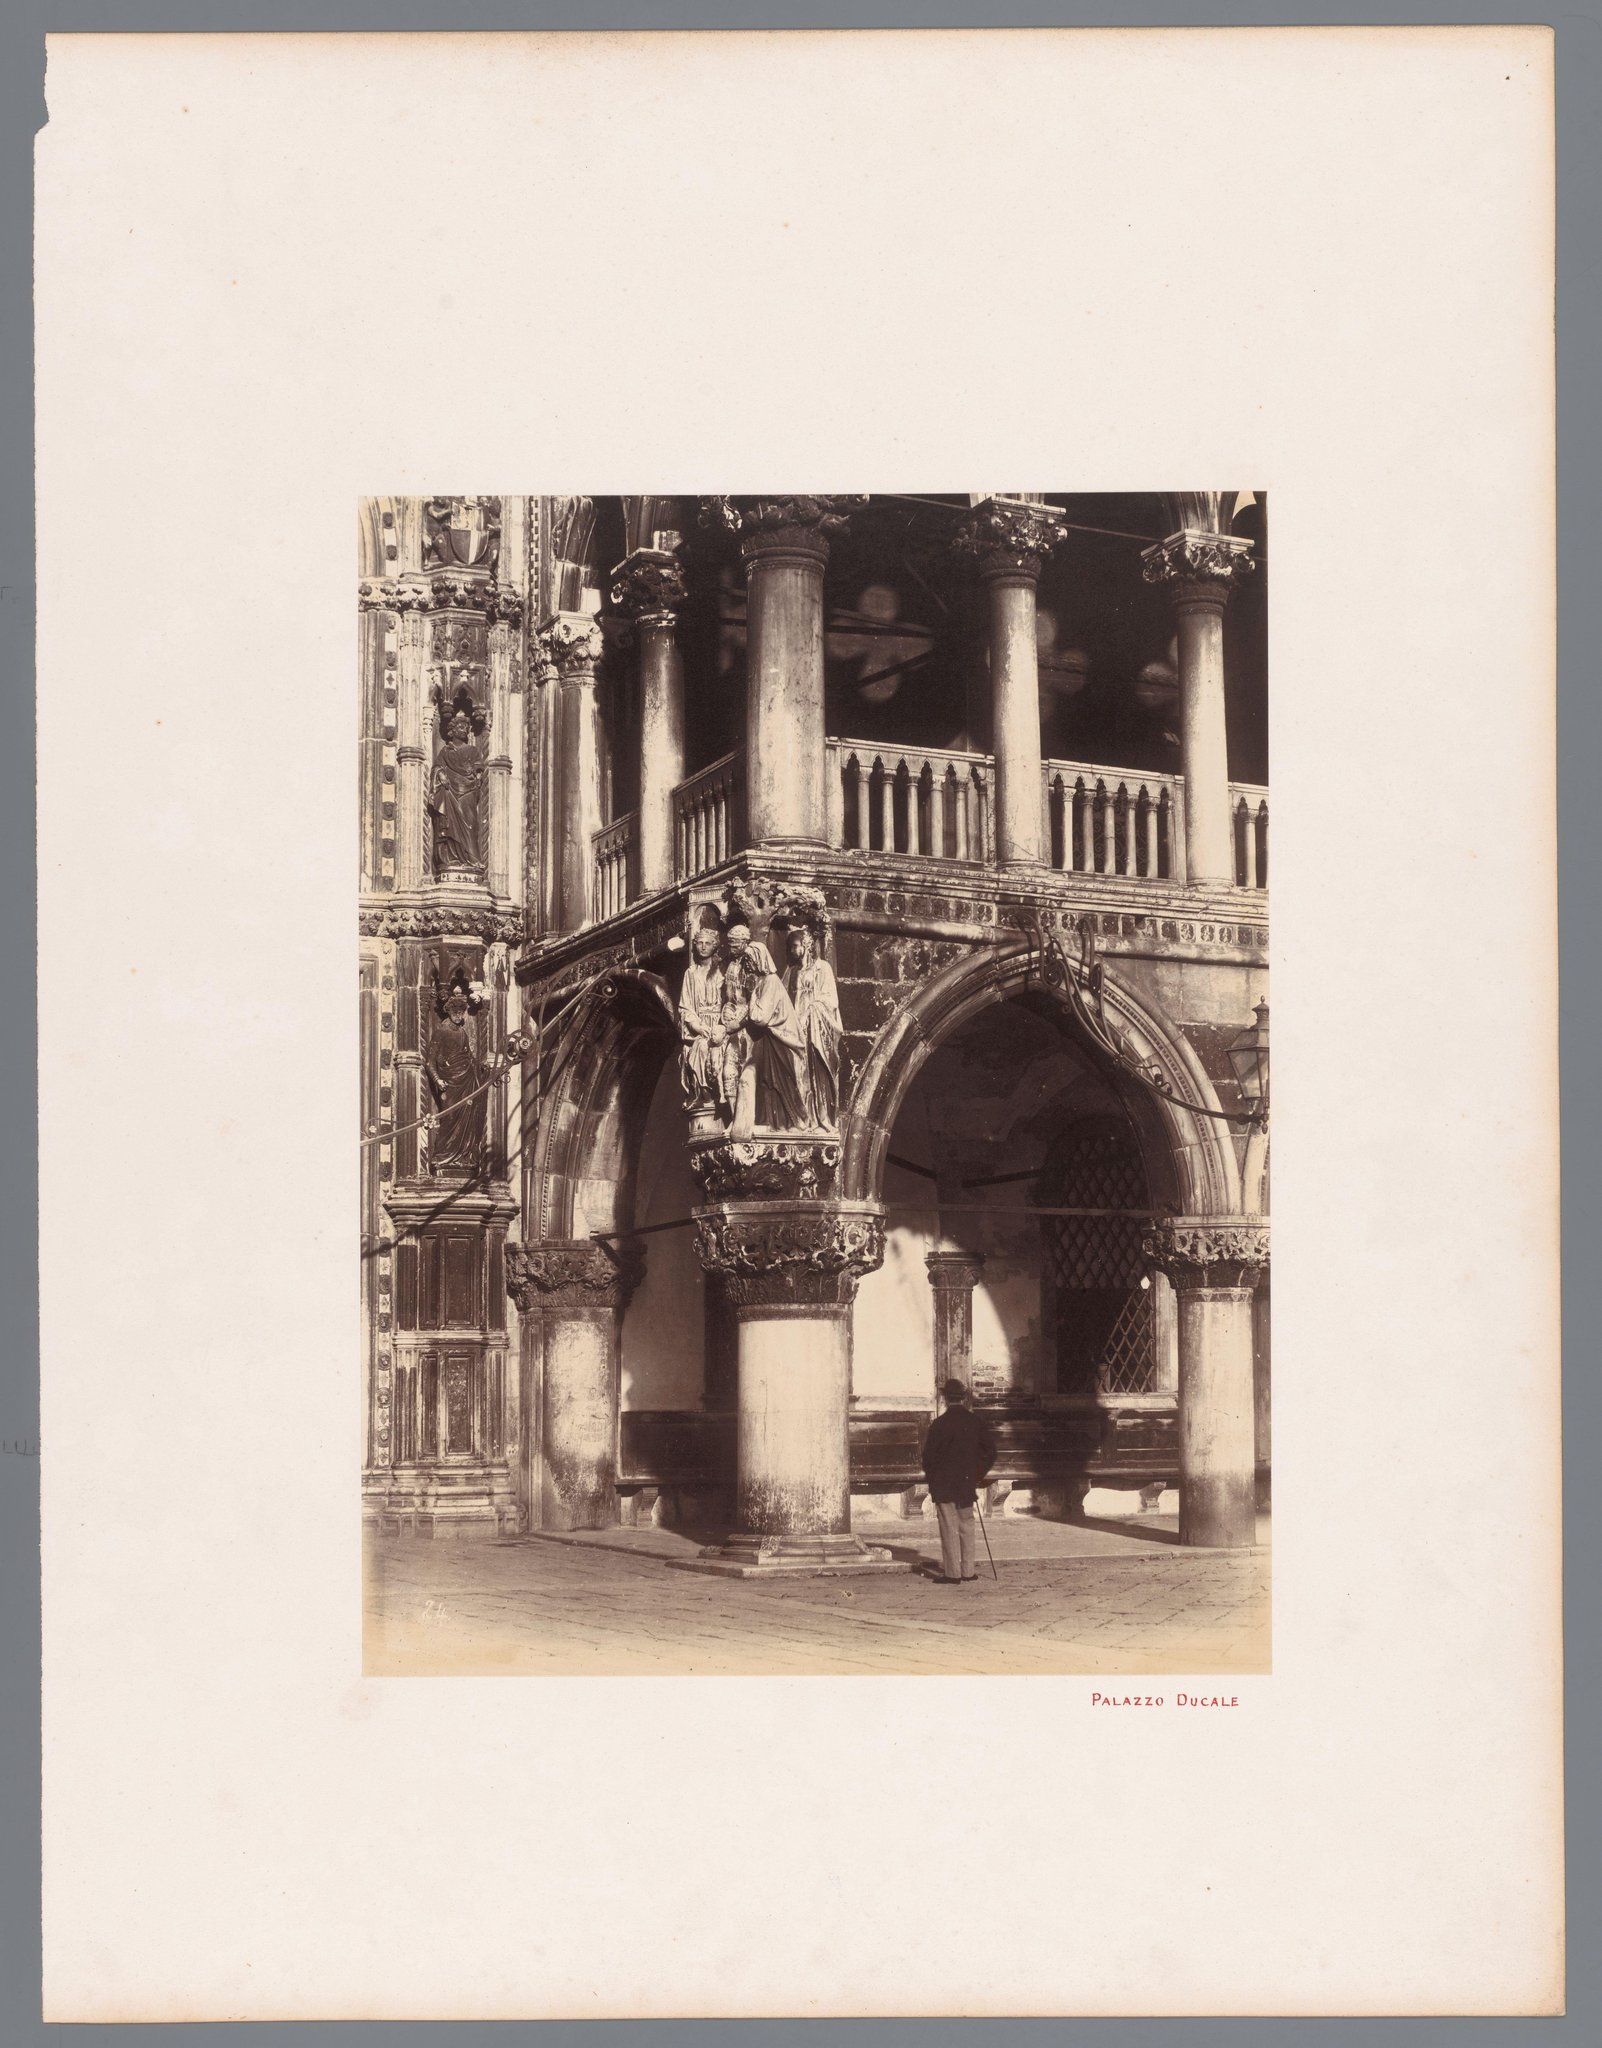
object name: photograph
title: Palazzo Ducale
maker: Anonymous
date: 1850-1870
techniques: albumen print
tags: dogepaleis